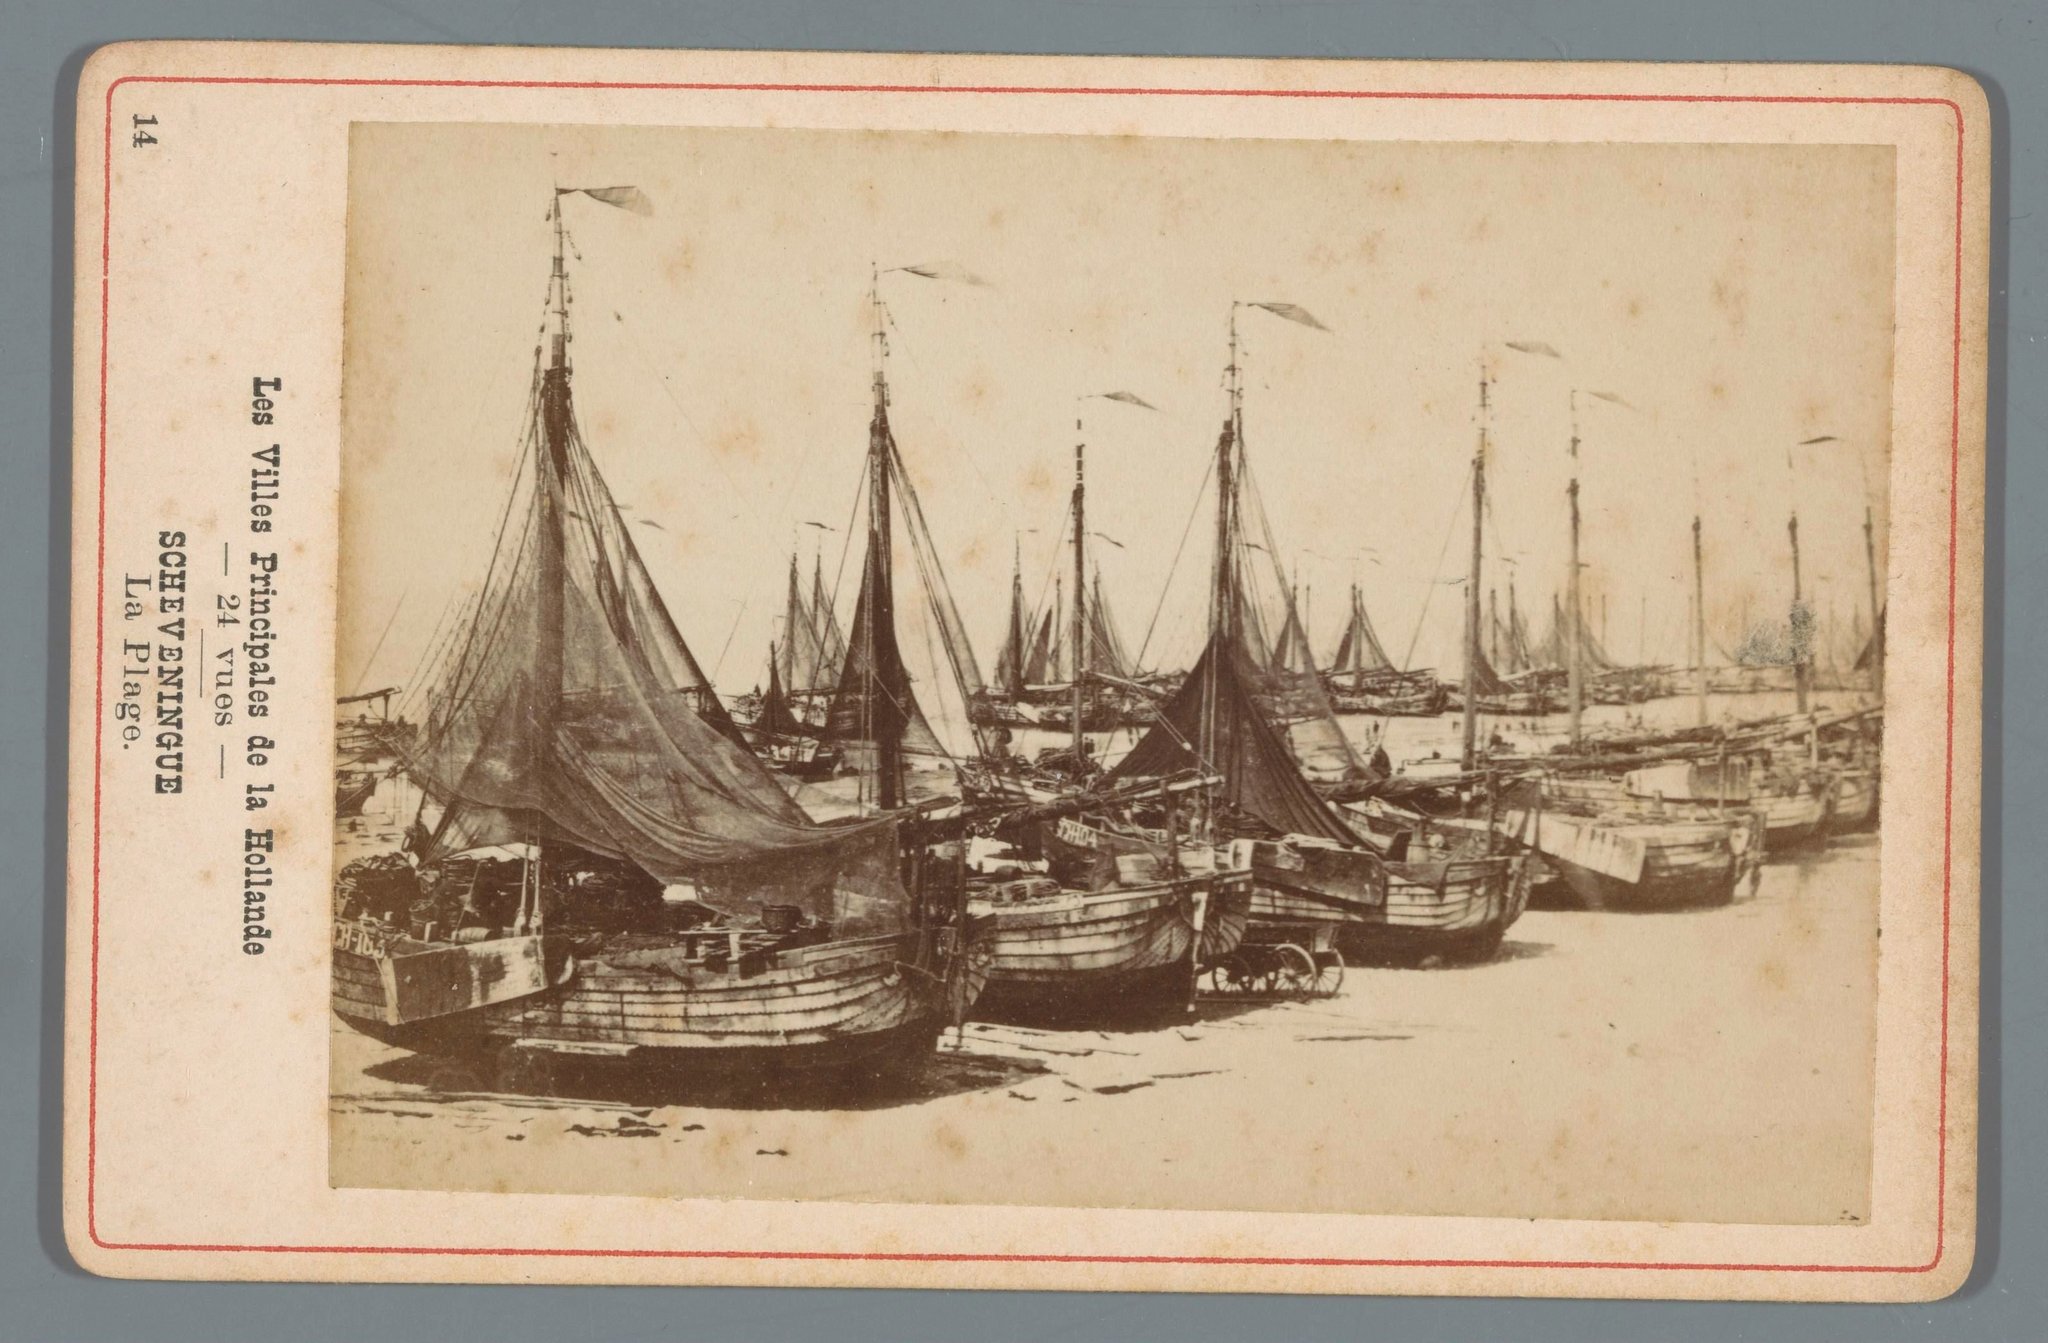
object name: photograph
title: Schepen op het strand te Scheveningen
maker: Anonymous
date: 1870-1890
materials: cardboard, photographic support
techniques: albumen print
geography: scheveningen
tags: ships, boats on land, beached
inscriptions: number: ‘14’